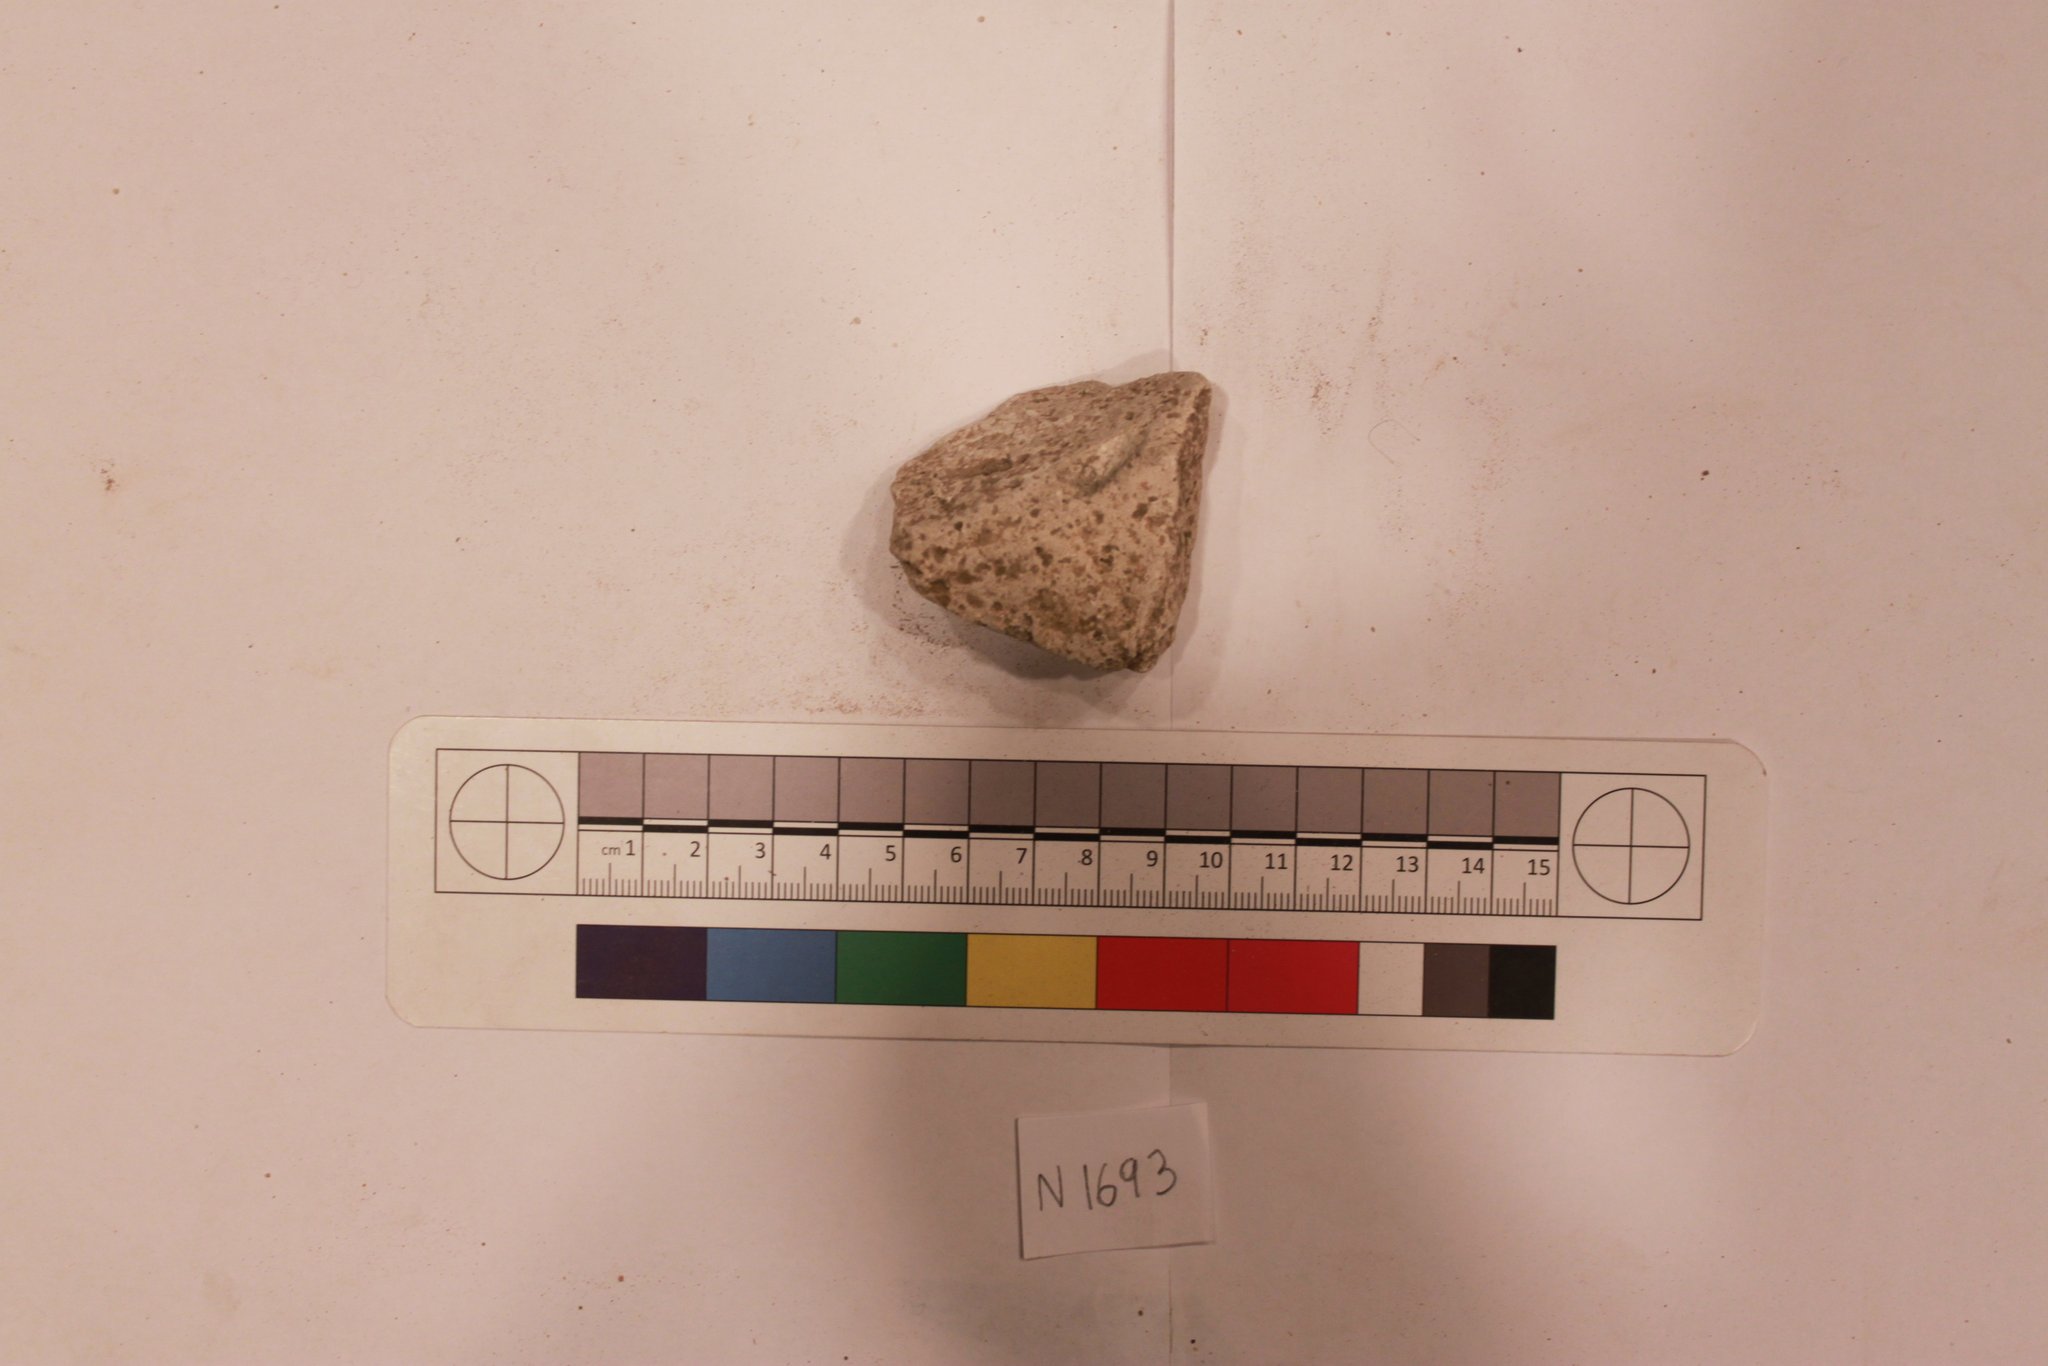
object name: fragment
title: Stucco Fragment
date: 701-1200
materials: plaster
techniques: carving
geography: iran